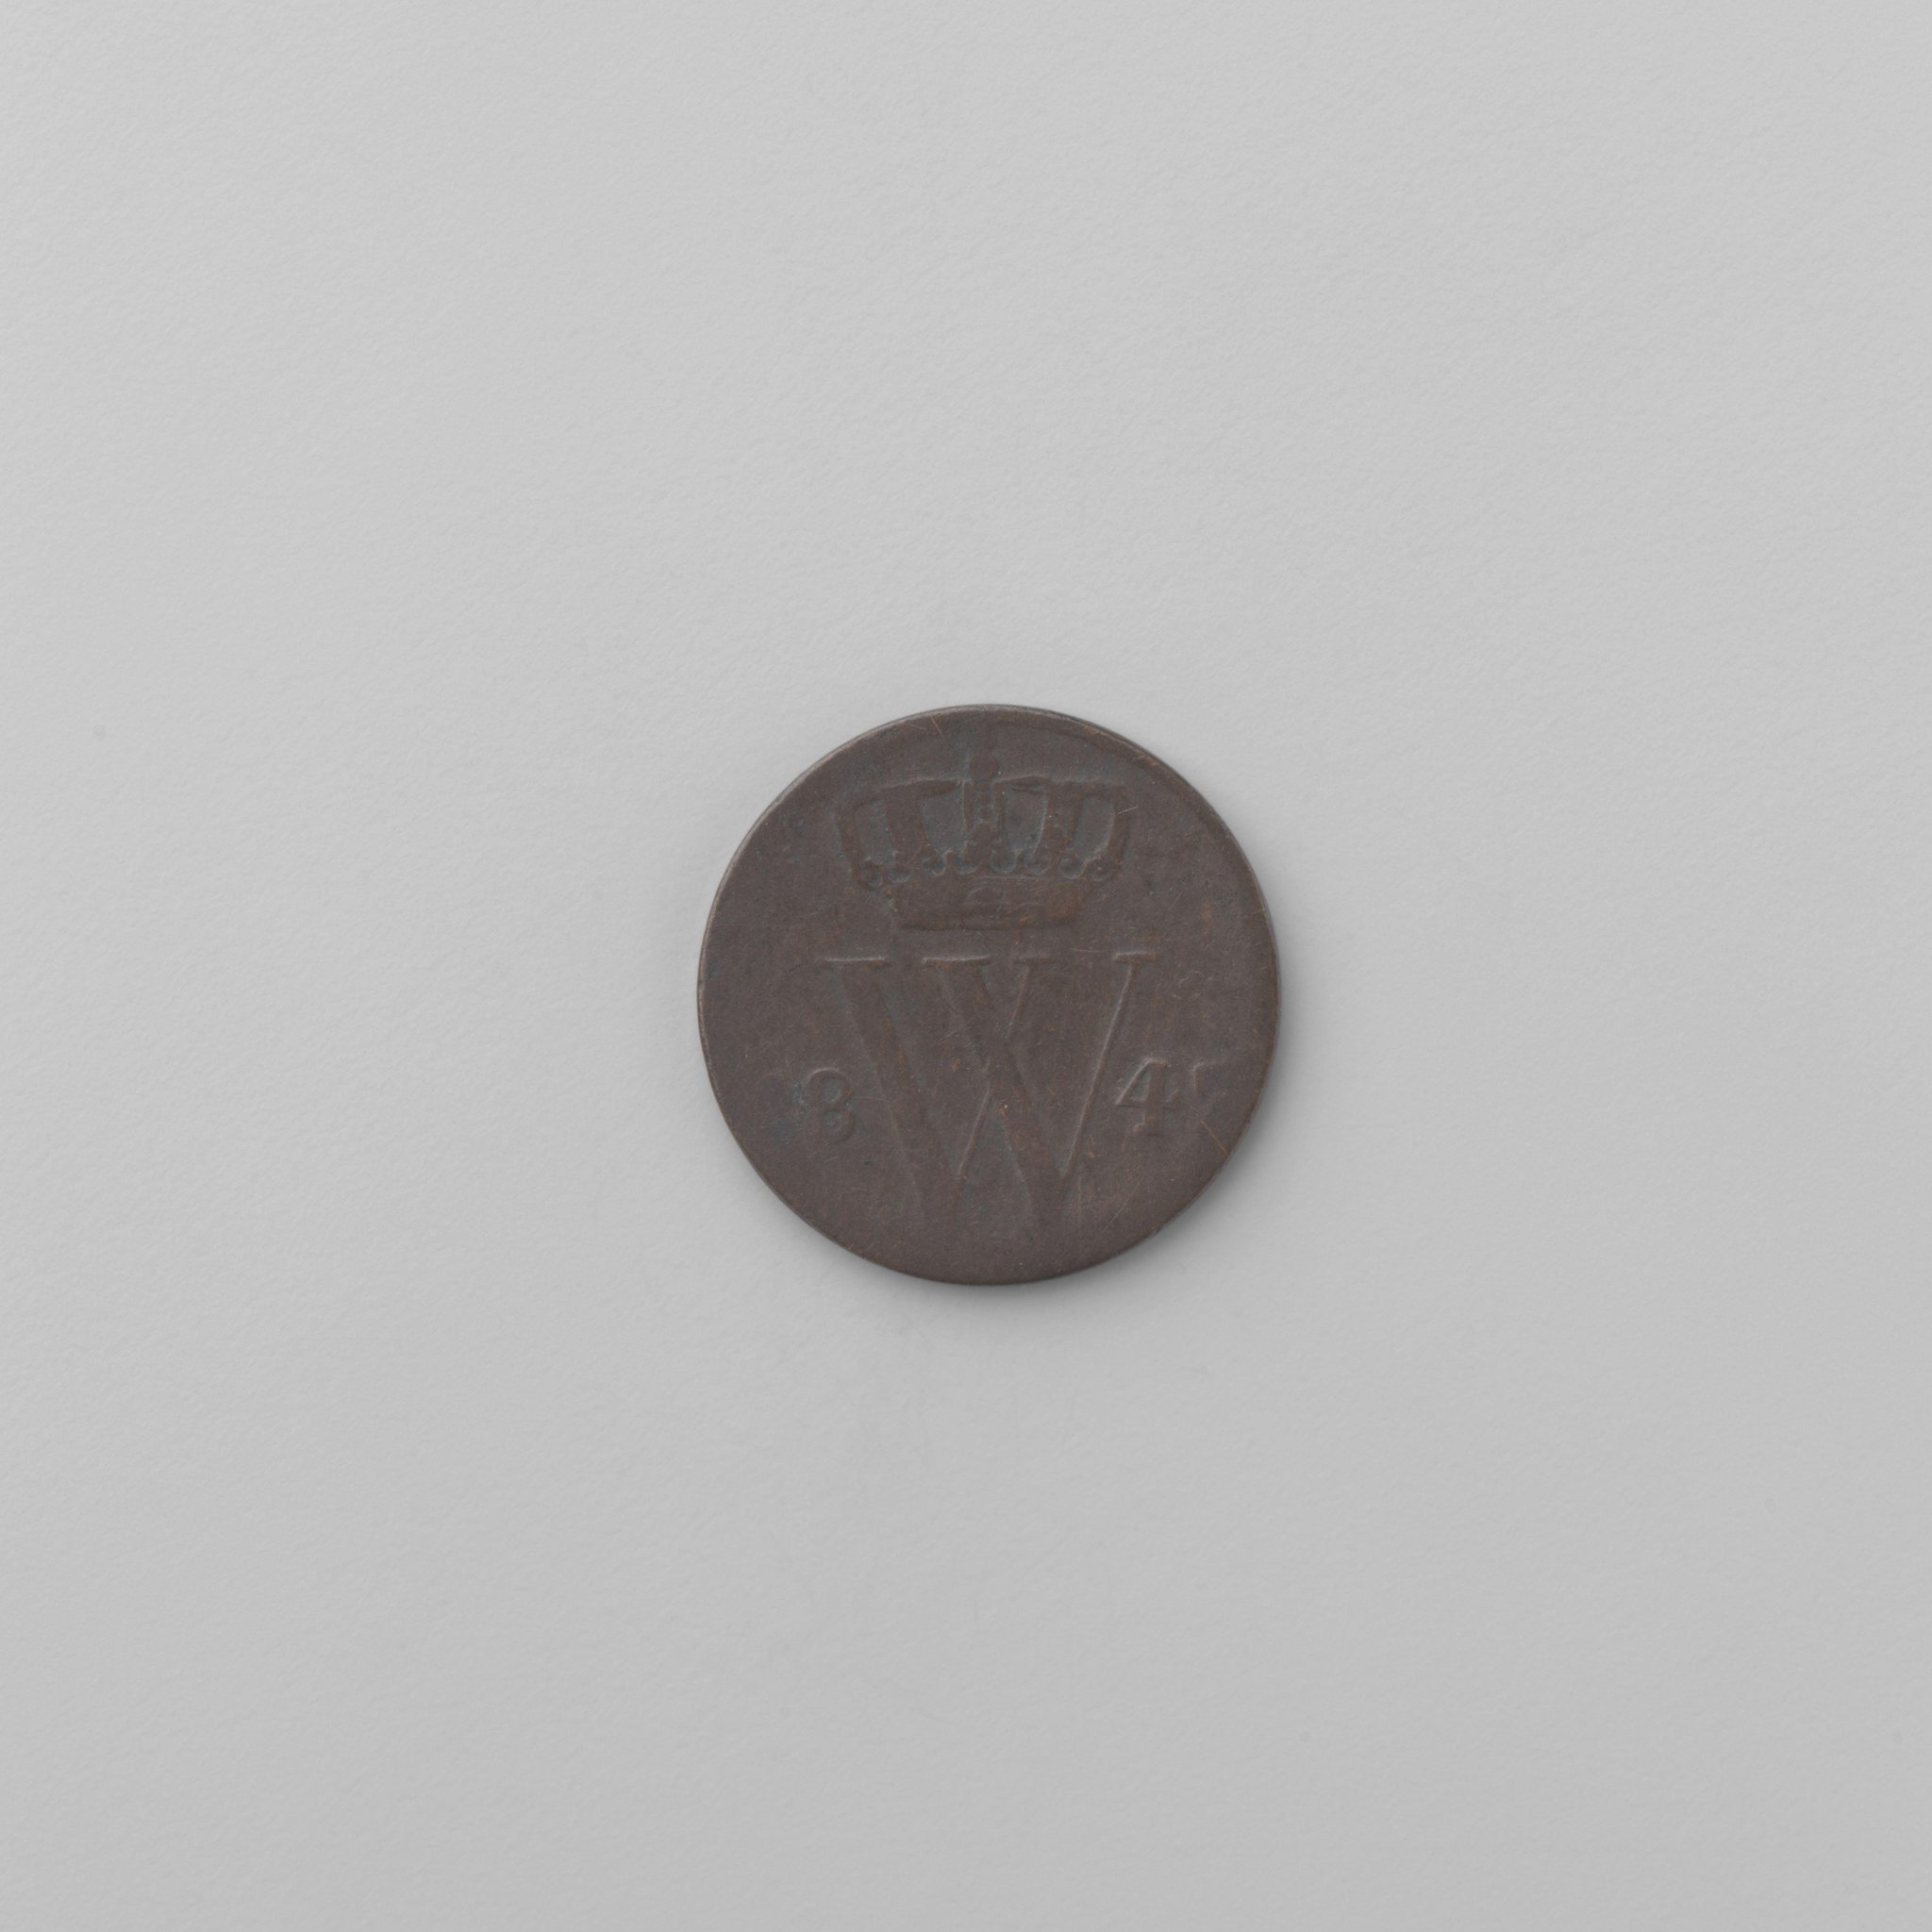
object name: coin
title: Nederland, ½ cent, 1843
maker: william ii of the netherlands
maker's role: koning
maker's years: 1792-1849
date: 1843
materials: copper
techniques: striking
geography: utrecht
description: Koperen munt. Voorzijde: tussen jaartal gekroonde rechte letter W. Keerzijde: tussen waarde-aanduiding ½ C. gekroond rijkswapenschild. Gladde rand.